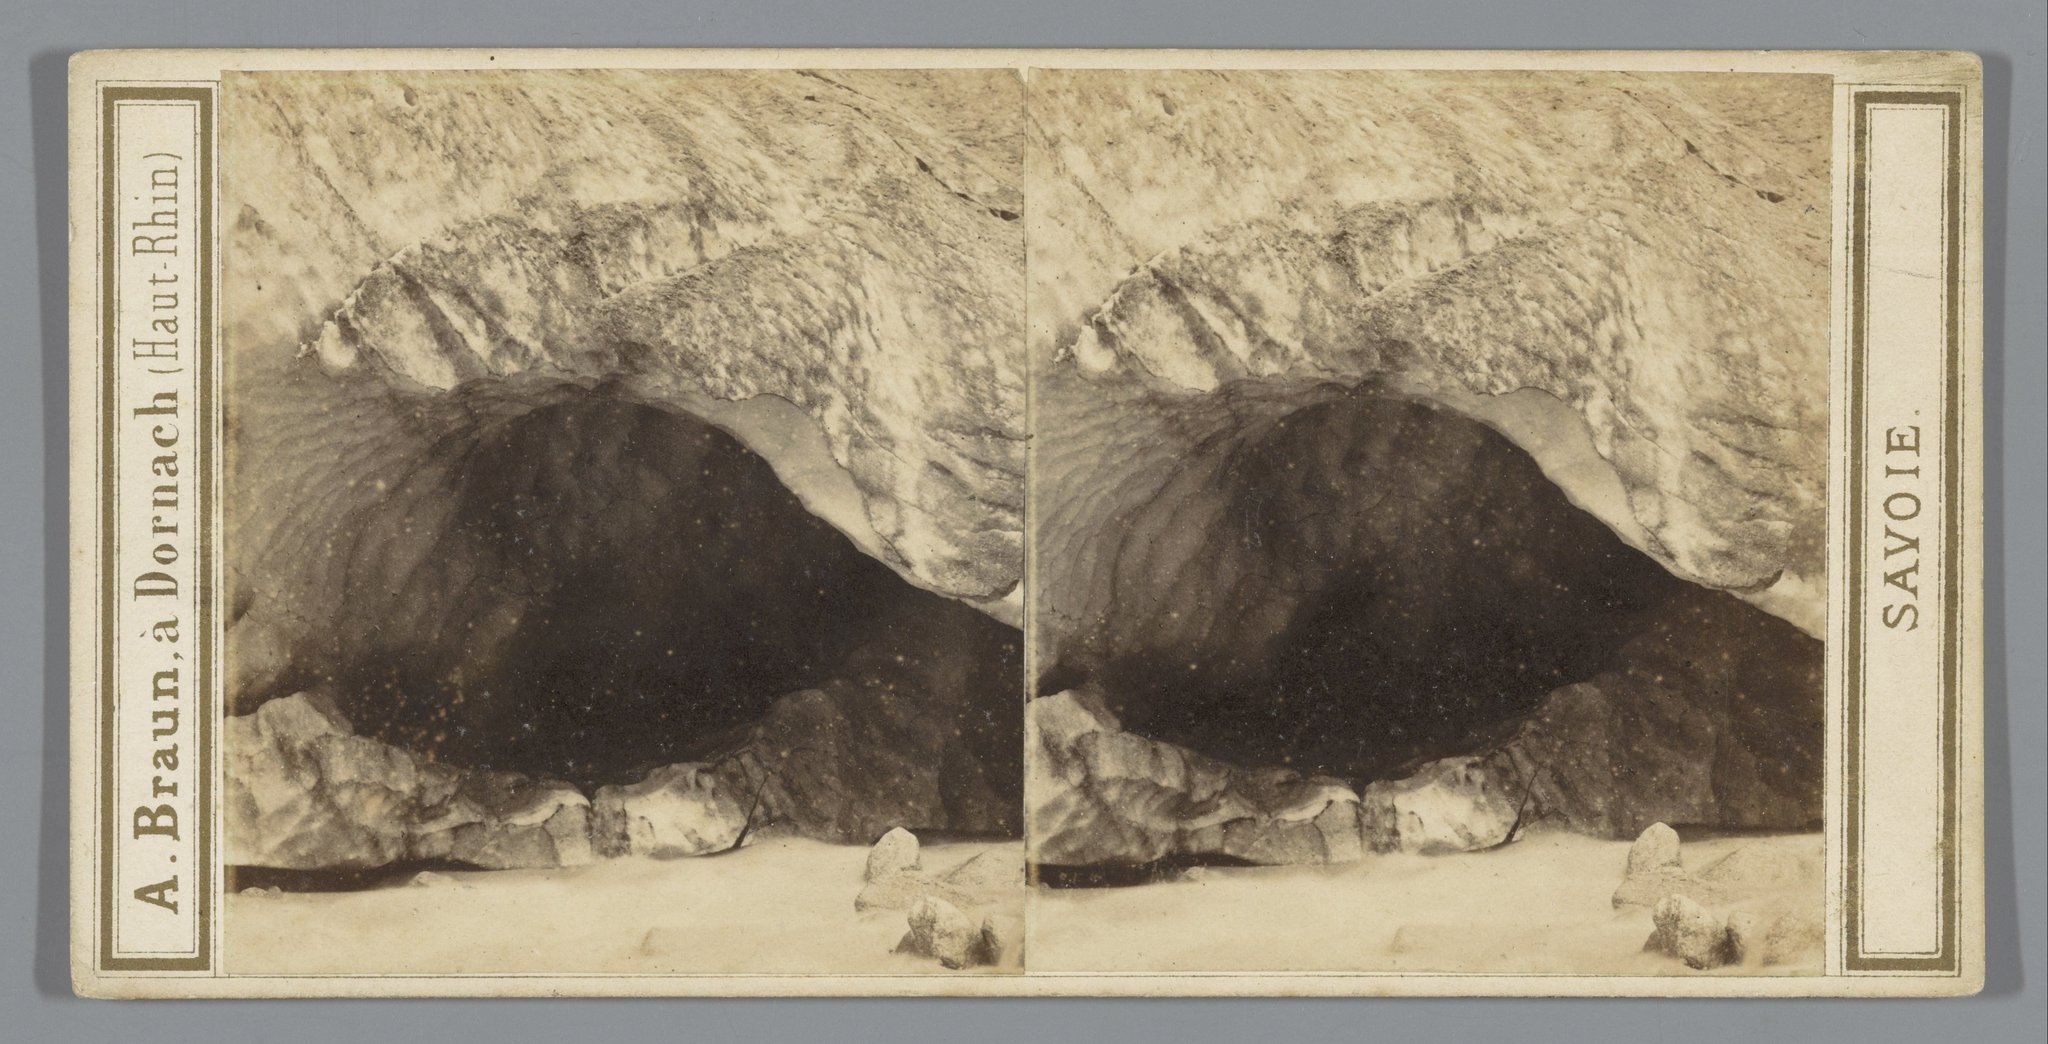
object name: stereograph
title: Source de l'Arveyron, au Glacier des Bois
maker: Anonymous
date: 1860-1866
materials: cardboard, paper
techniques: albumen print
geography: dornach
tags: cave, grotto, glacier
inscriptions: number: ‘No 1023.’, number: ‘75’, retailer's mark: ‘D. WAKKER/ Kalverstraat/ bij de Heiligenweg D. 133’